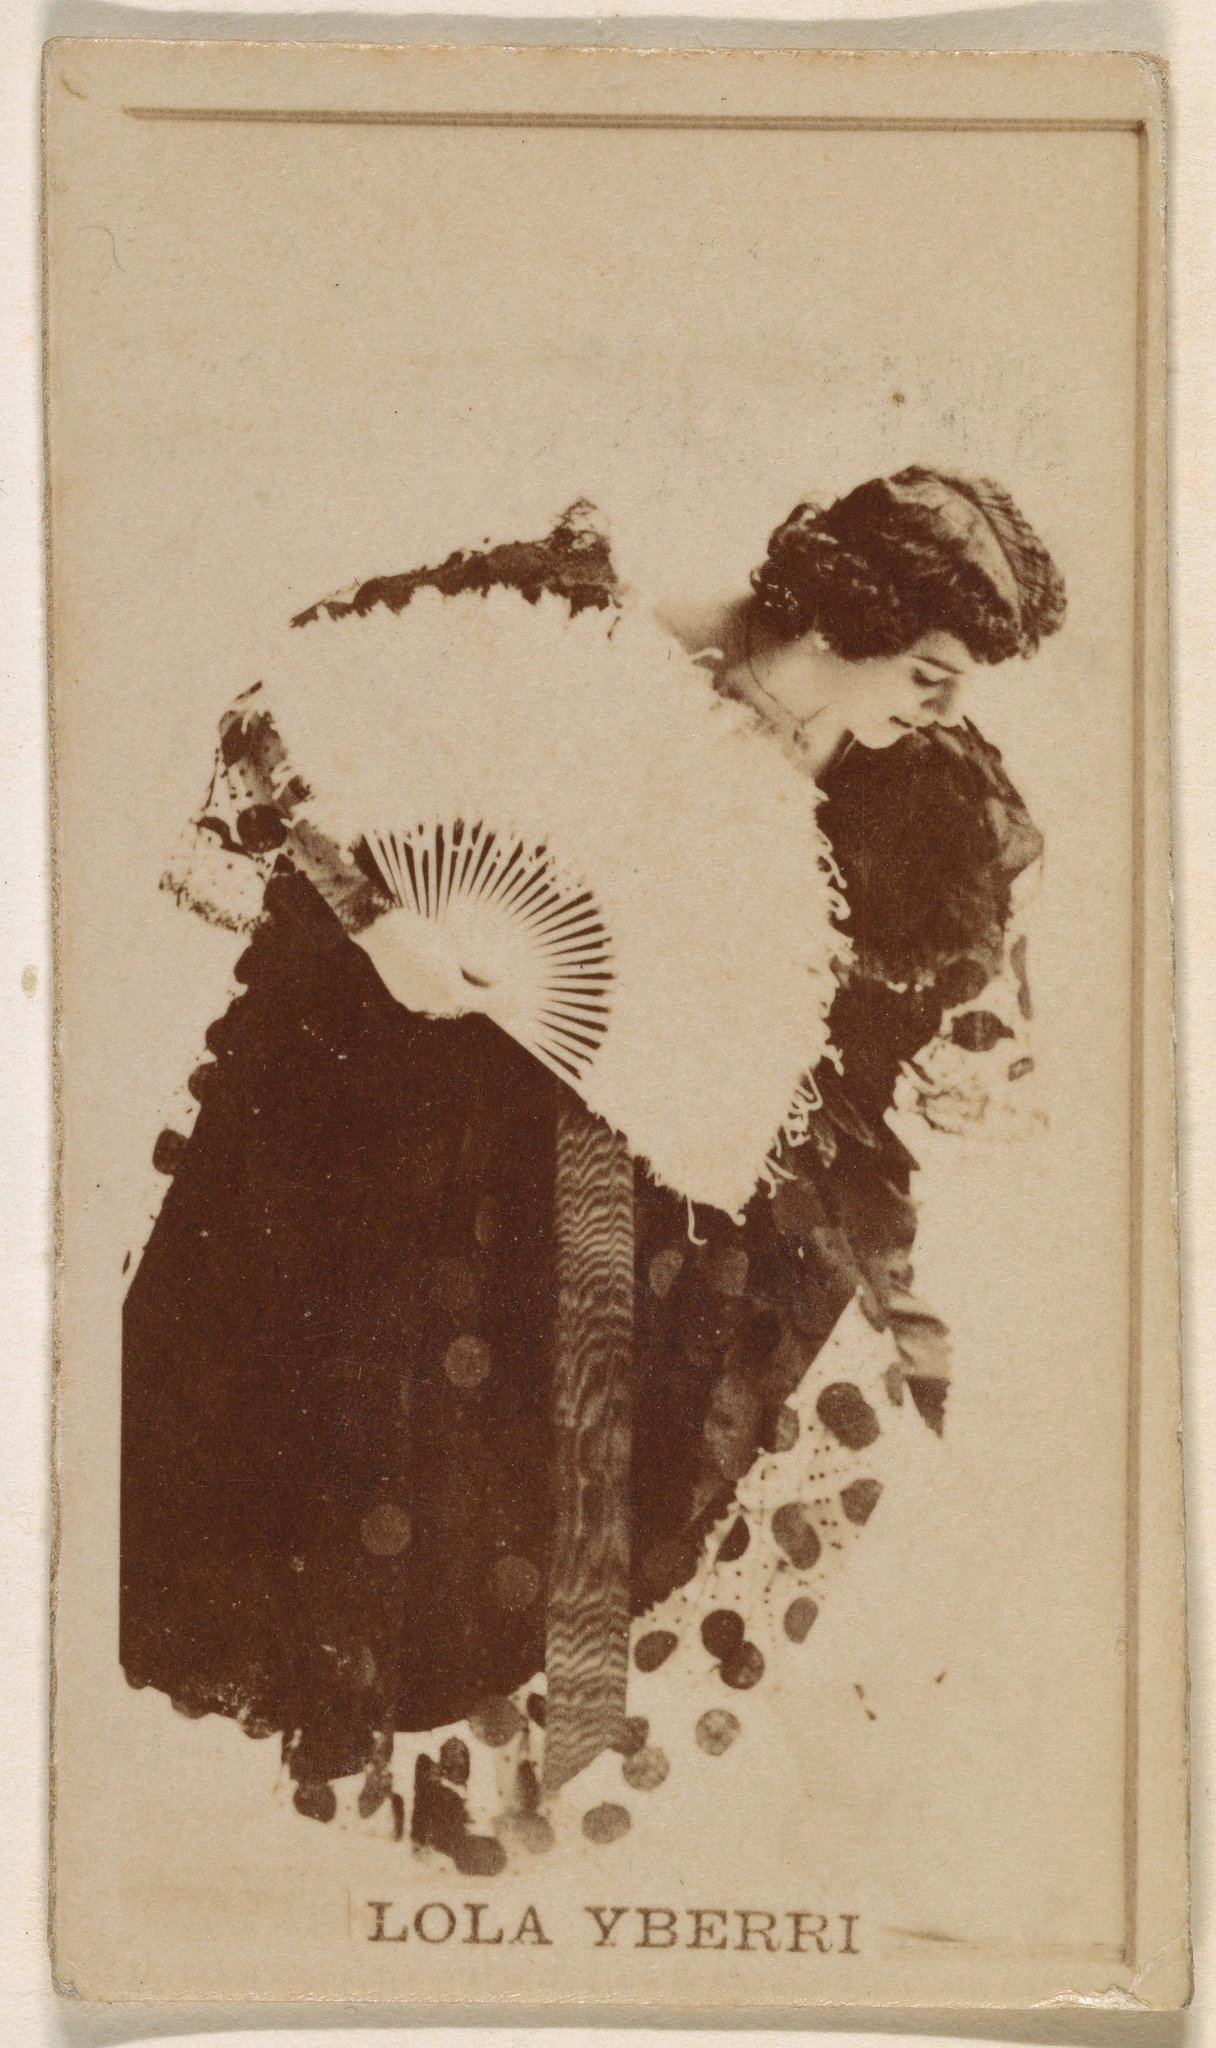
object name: photograph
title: Lola Yberri, from the Actresses series (N245) issued by Kinney Brothers to promote Sweet Caporal Cigarettes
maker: kinney brothers tobacco company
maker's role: publisher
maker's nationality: american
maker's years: 1869-2011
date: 1890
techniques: albumen silver print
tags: women,actresses